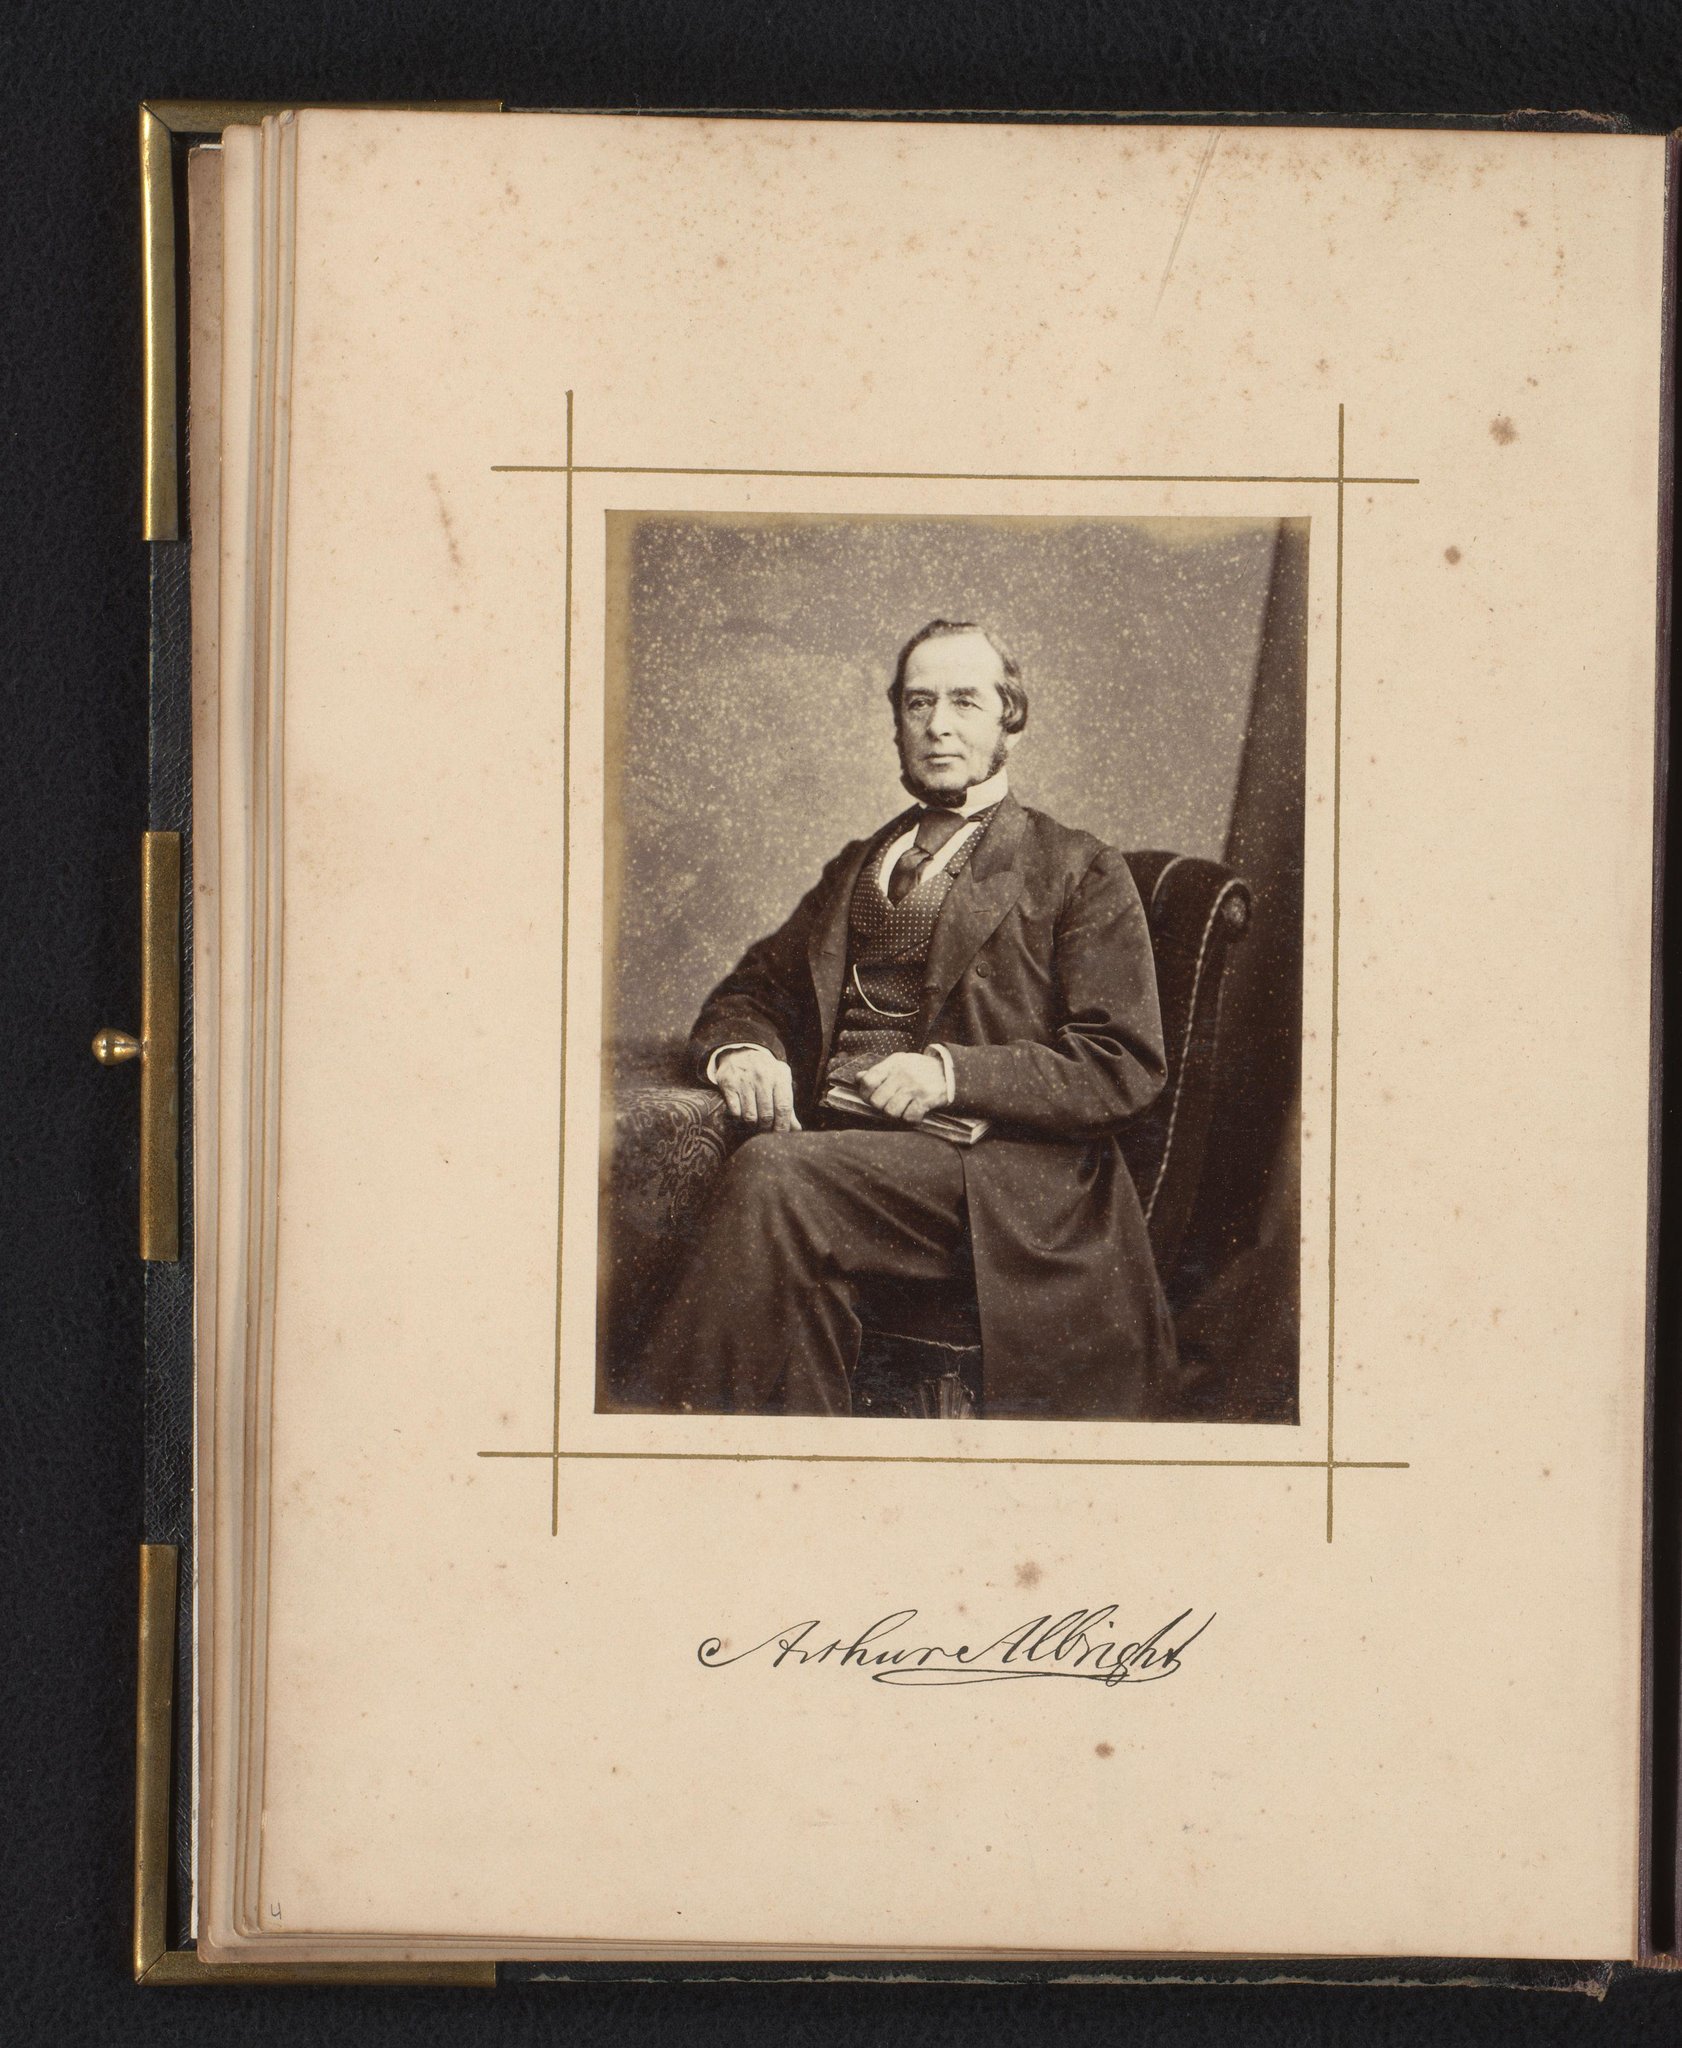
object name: photograph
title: Portret van Arthur Albright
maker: Anonymous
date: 1866-1871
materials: photographic support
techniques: albumen print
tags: historical persons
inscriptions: name: ‘Arthur Albright’